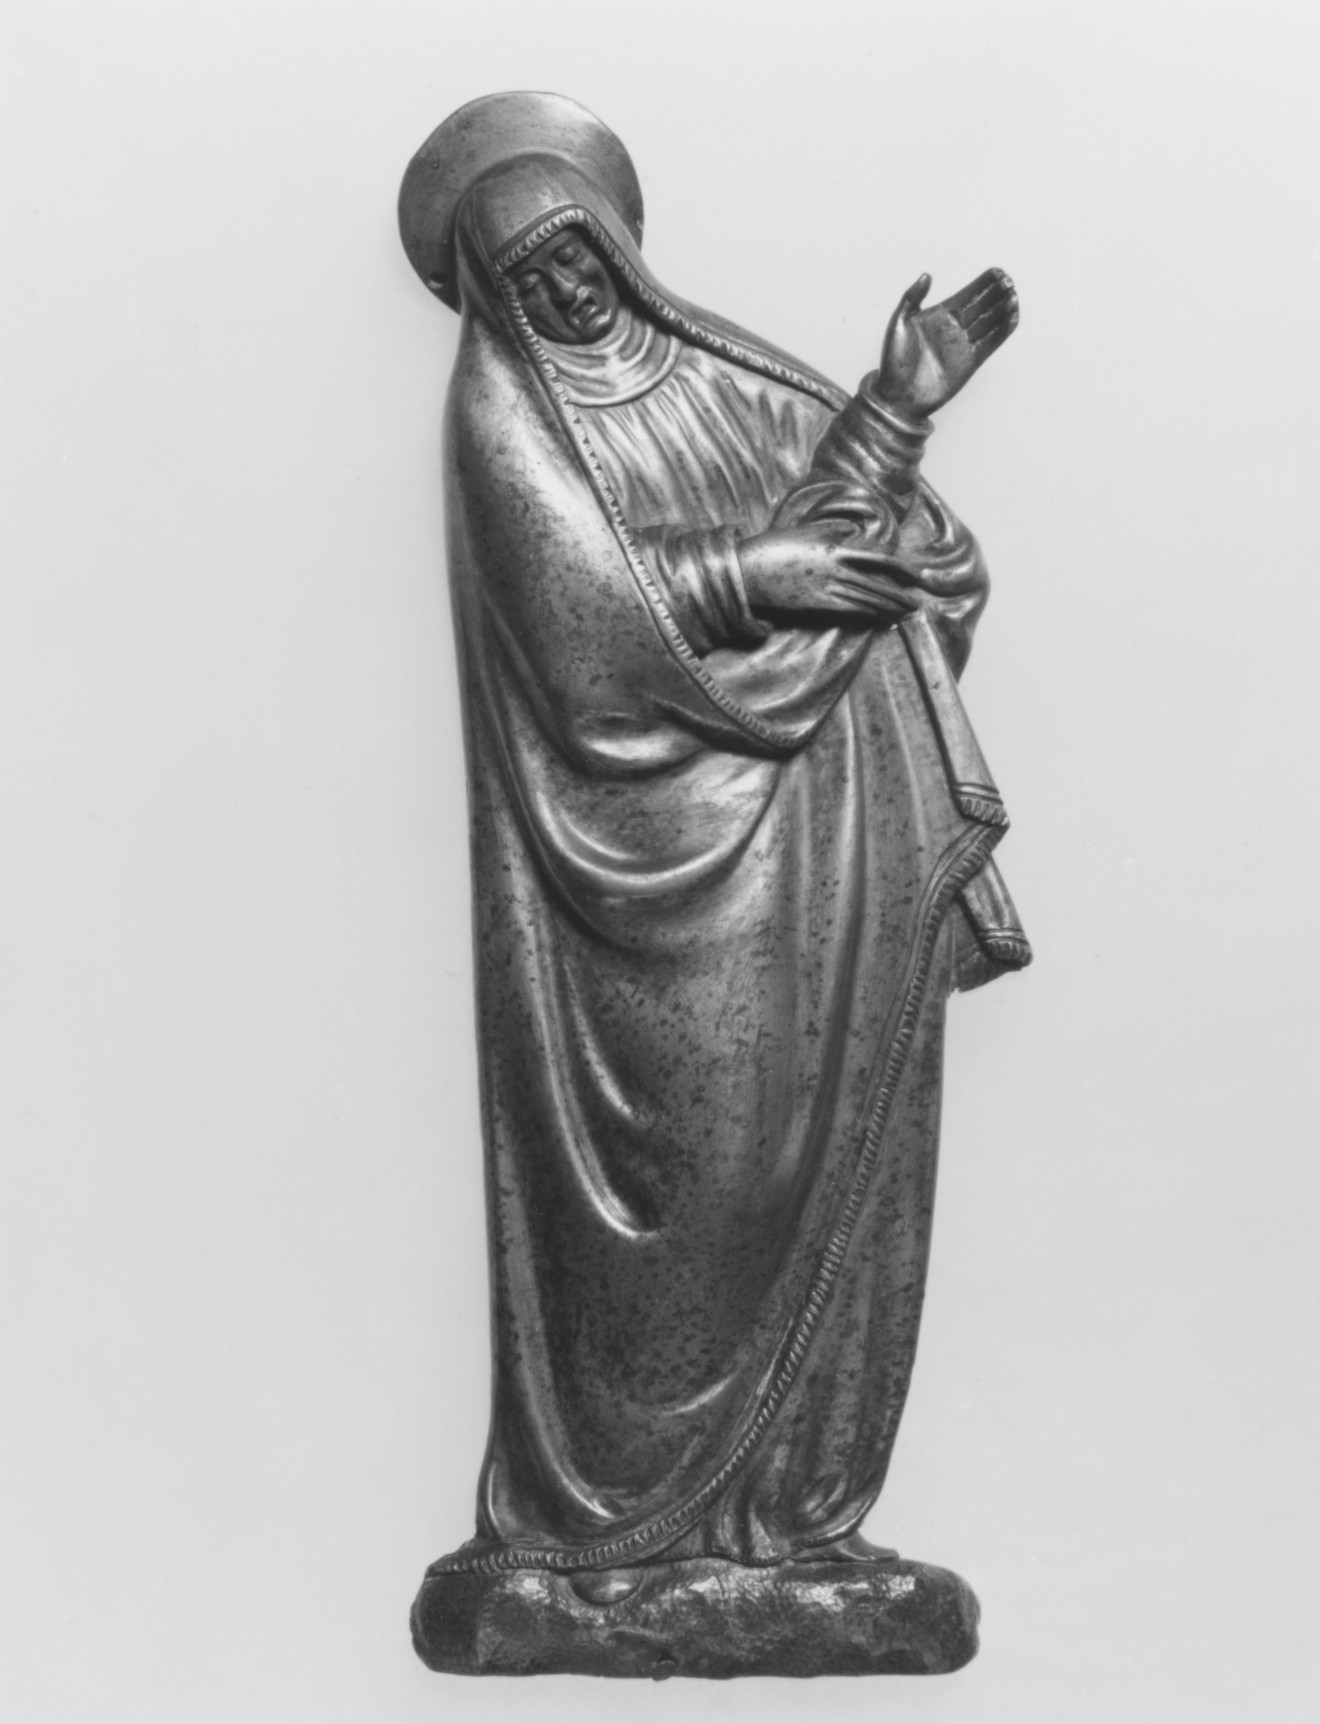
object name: relief figure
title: Mourning Virgin from a Crucifixion Group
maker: benedetto da maiano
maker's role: designer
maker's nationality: italian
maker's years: 1442-1497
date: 1401-1500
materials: bronze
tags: sadness,virgin mary